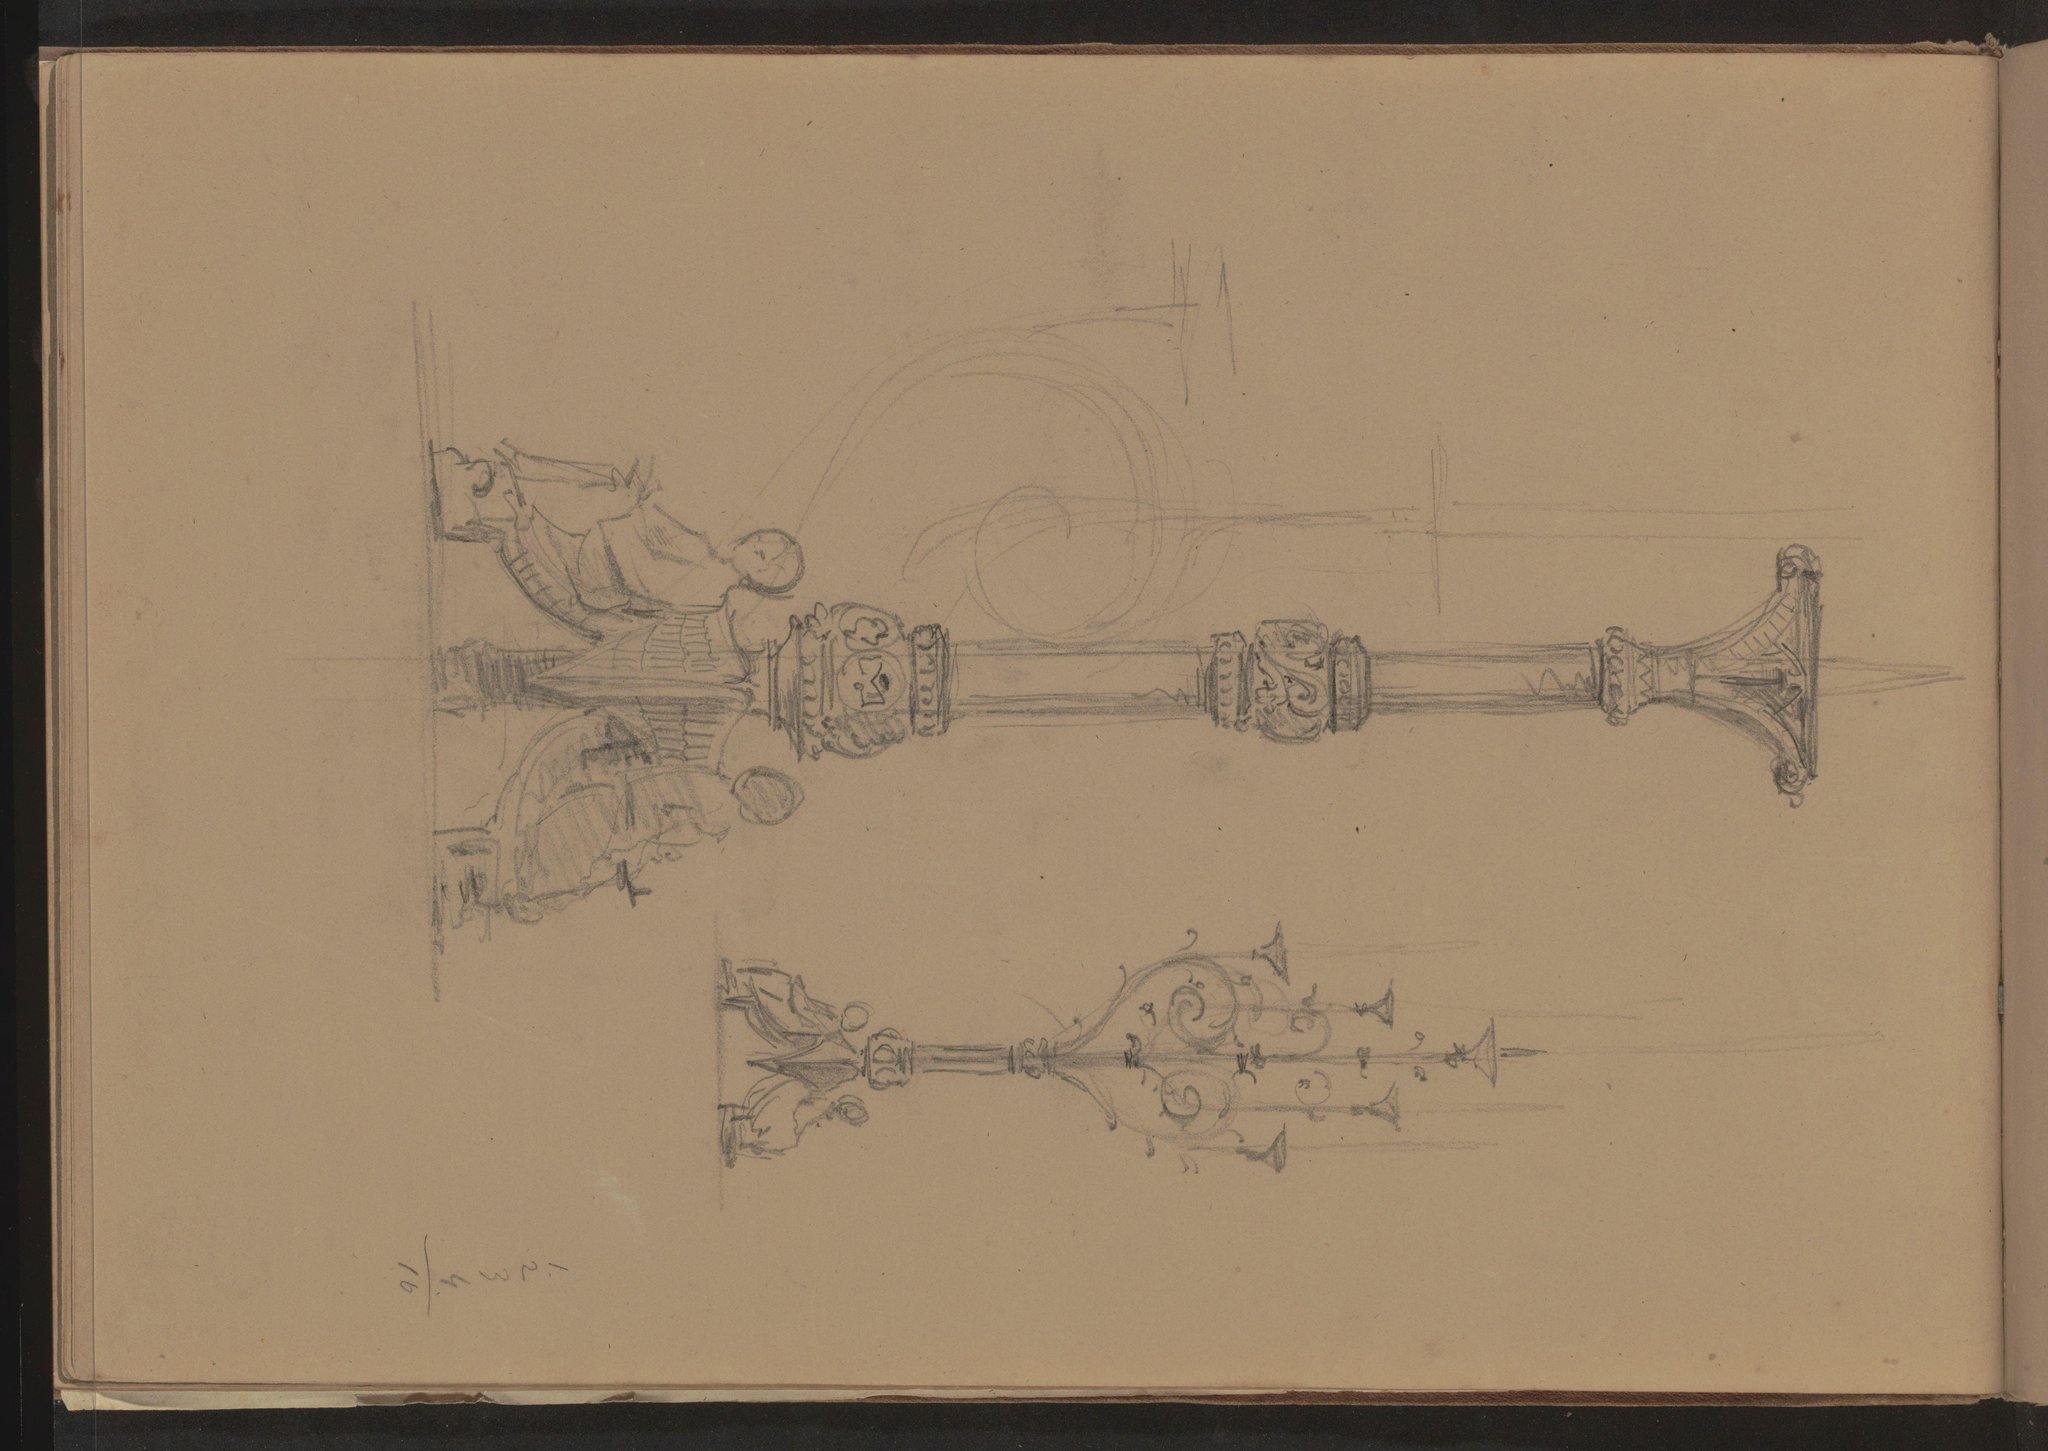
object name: sketchbook leaf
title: Kandelaars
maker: pierre joseph hubert cuypers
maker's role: draughtsman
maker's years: 1827-1921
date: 1837-1921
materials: paper, pencil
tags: candlestick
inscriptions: annotation: ‘[...]’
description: De voeten van de kandelaars zijn versierd met zittende engelen. Blad 15 verso uit een schetsboek met 23 bladen.